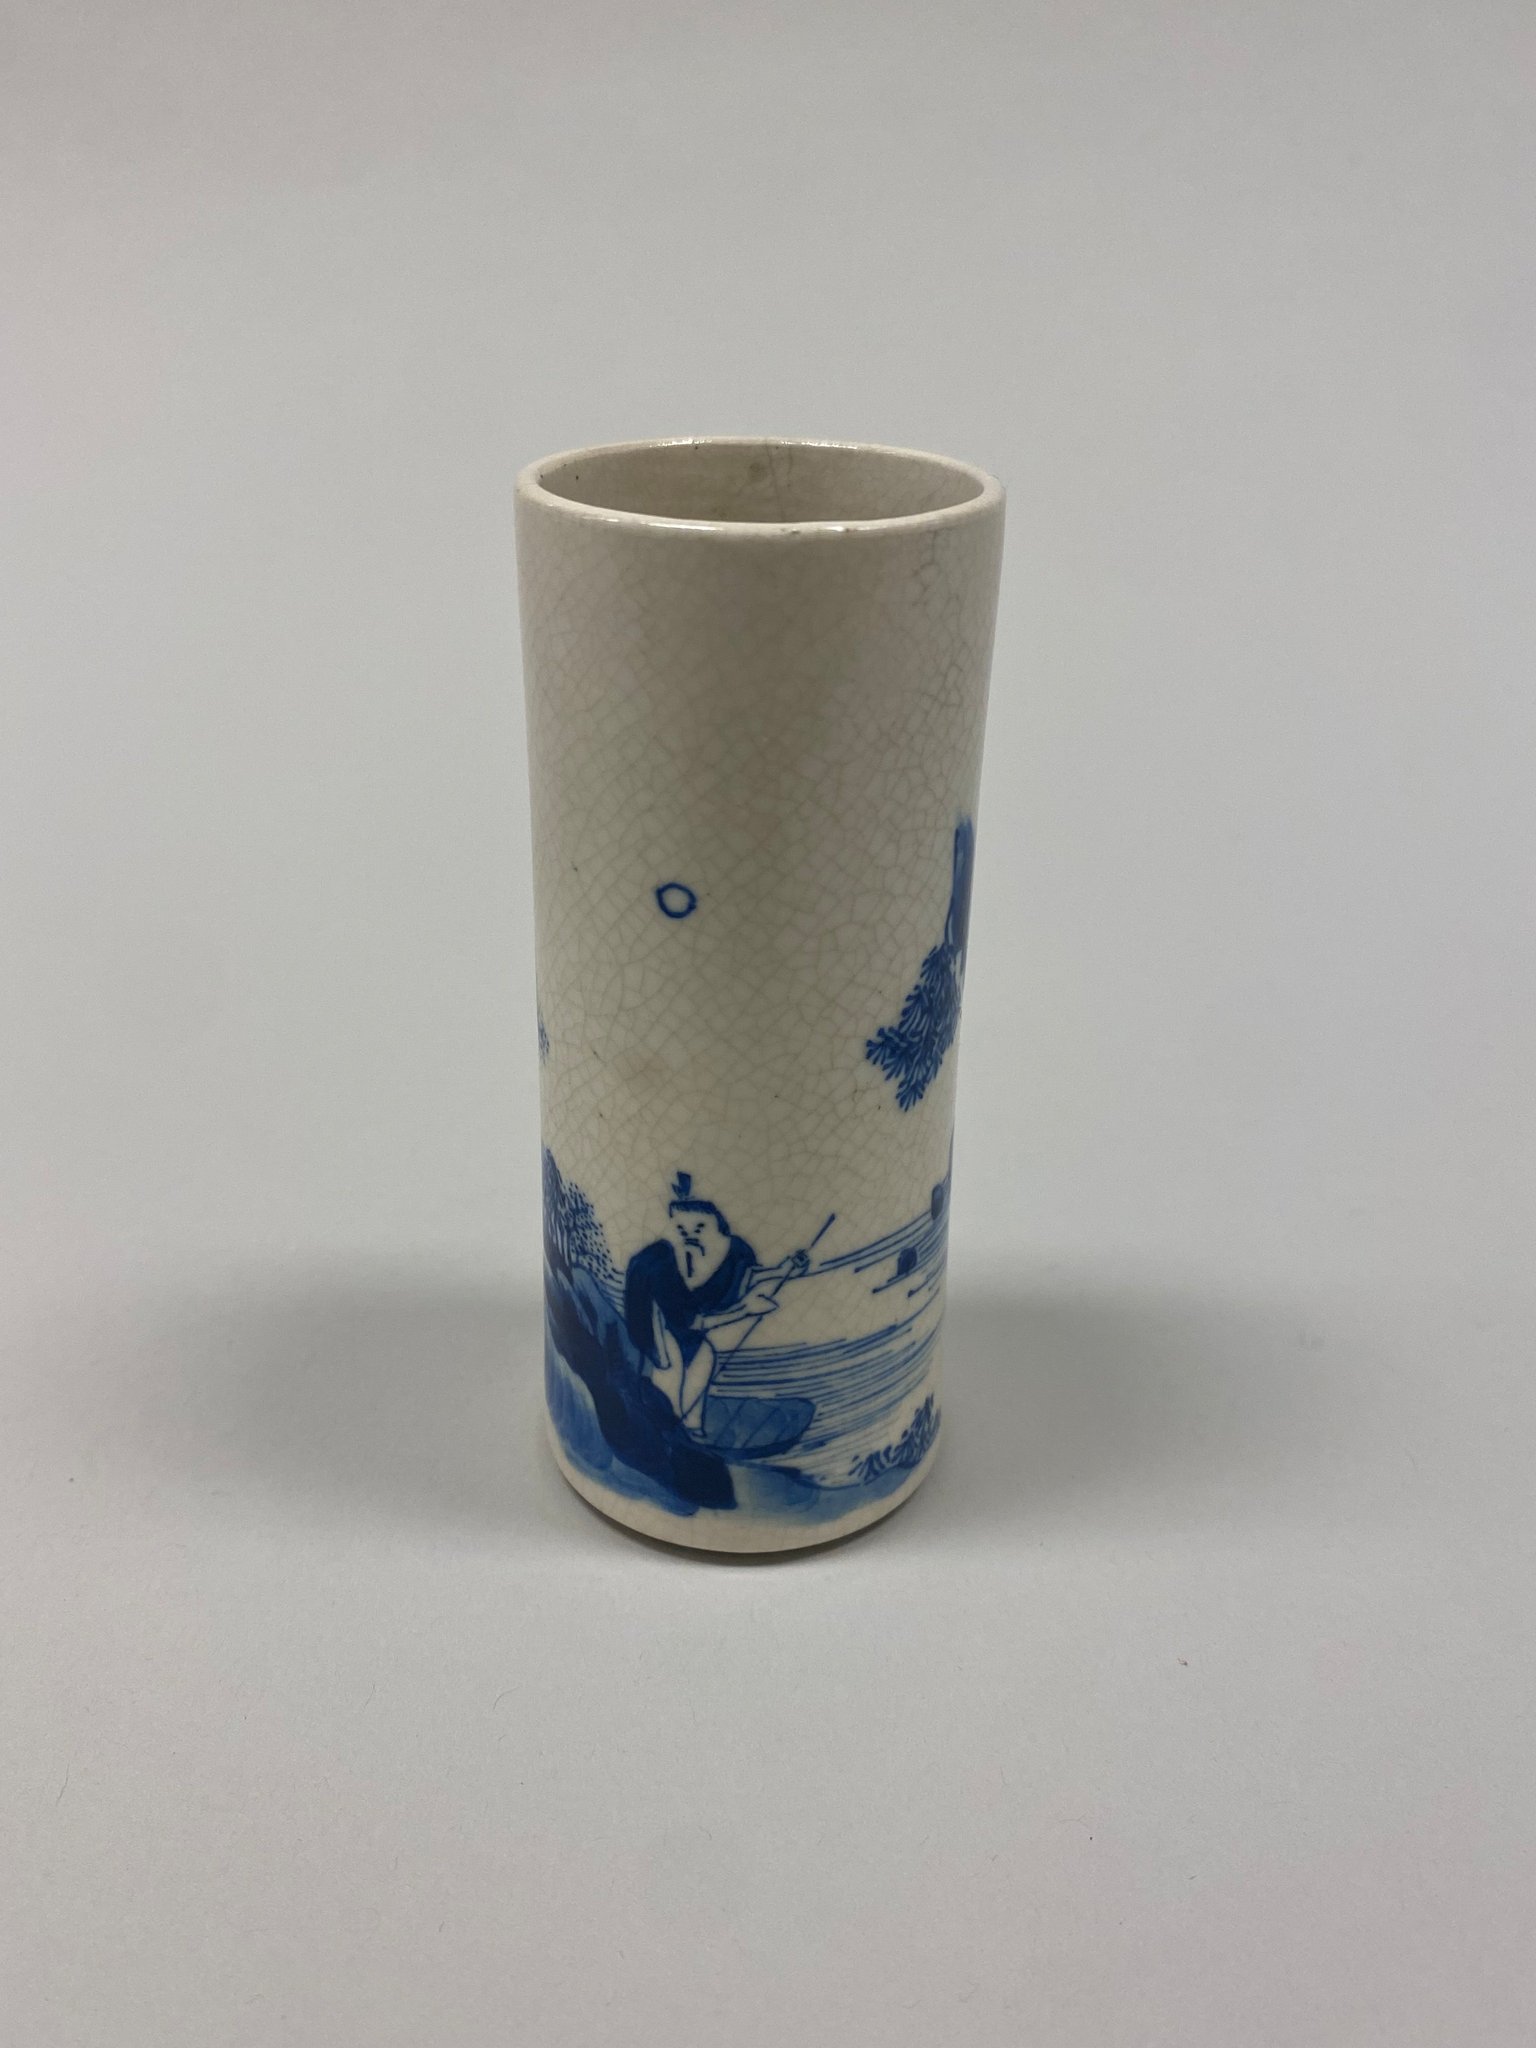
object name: bird feeder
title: Bird feeder with fisherman in a landscape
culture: chinese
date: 1701-1800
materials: enamel, porcelain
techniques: overglaze, painting, polychrome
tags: men